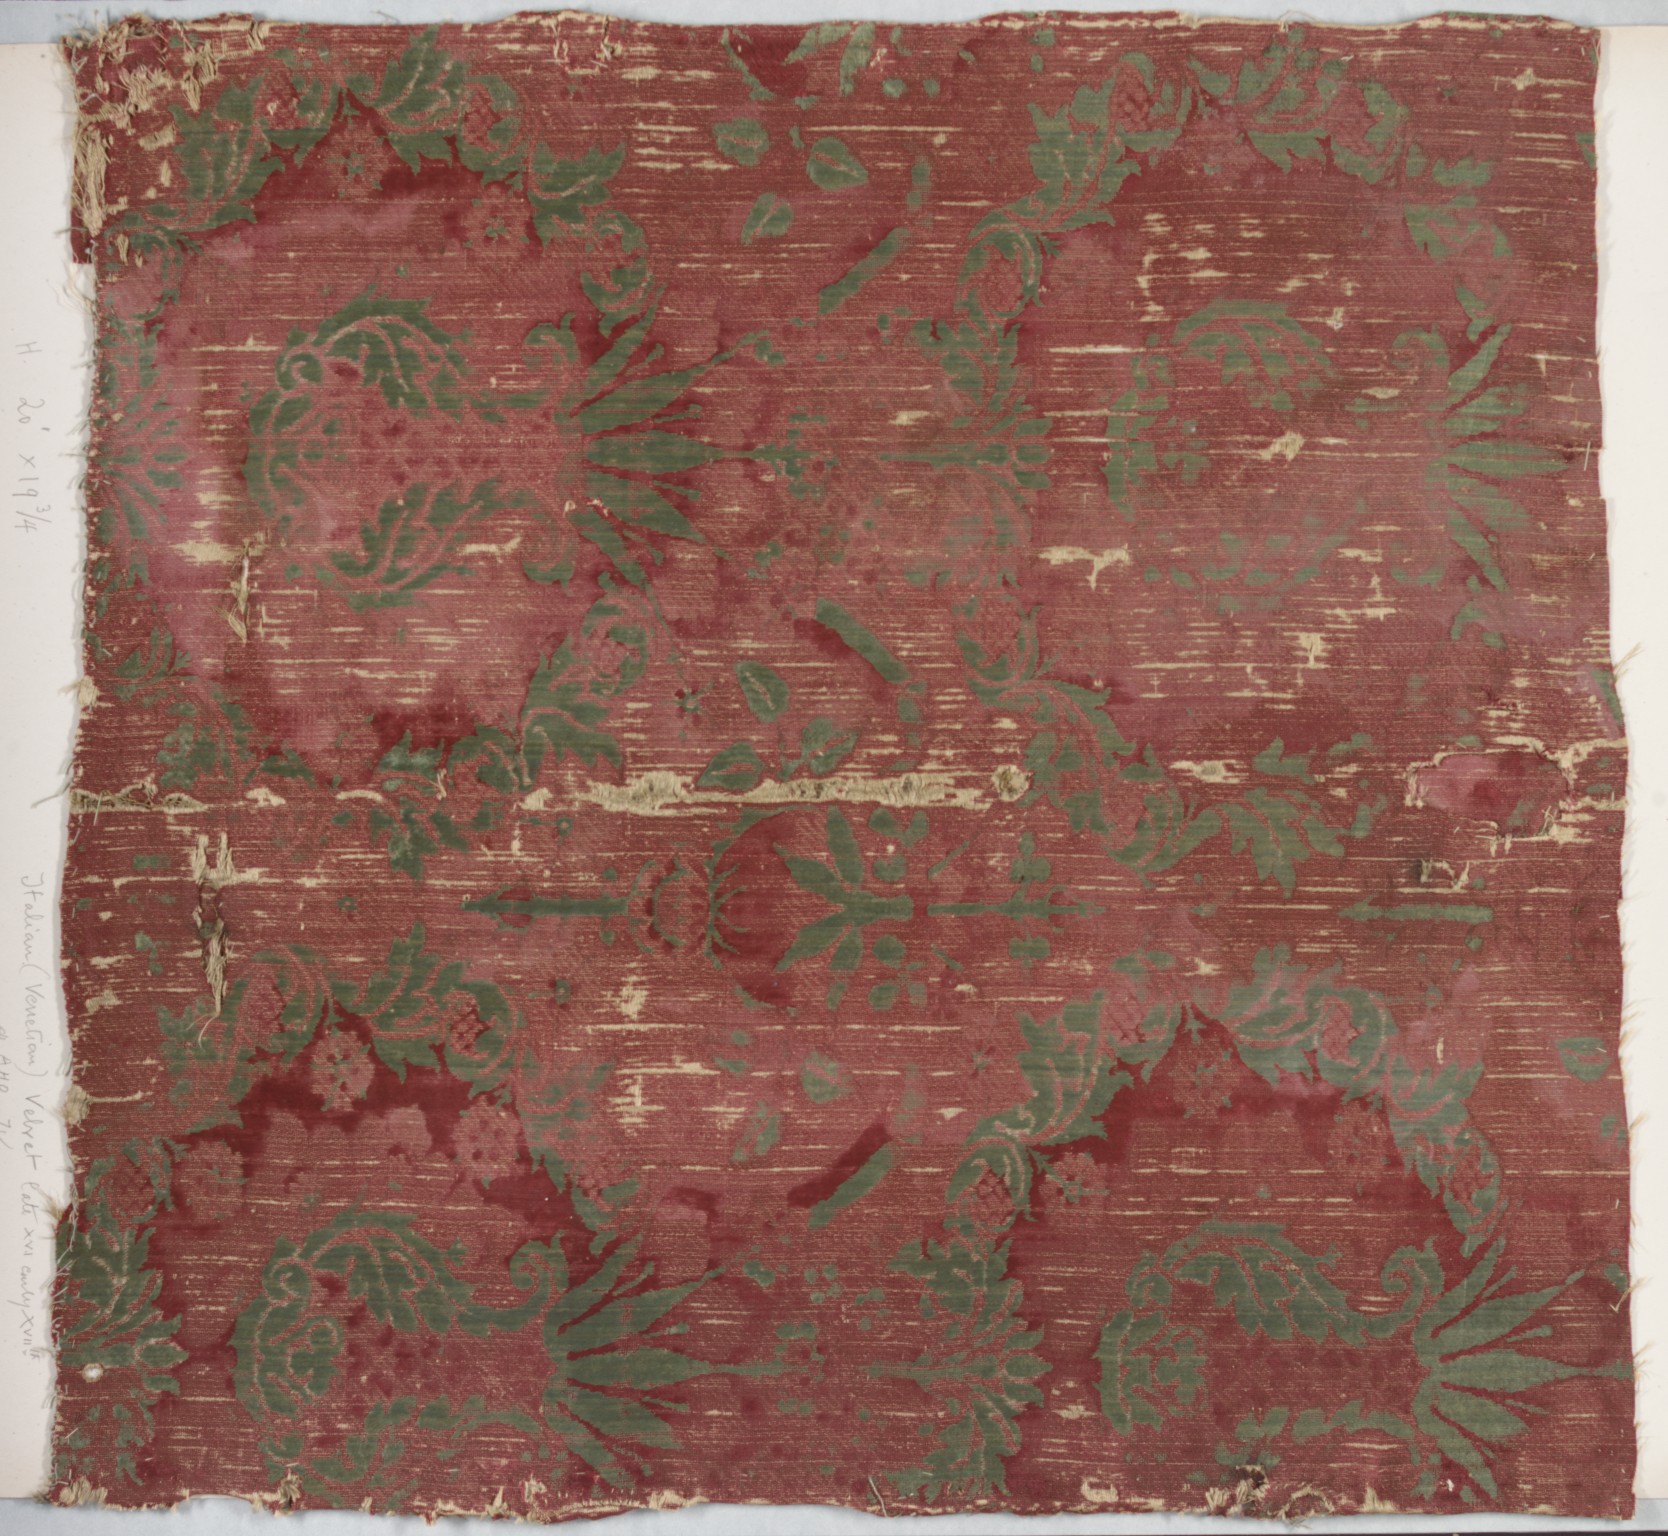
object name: fragment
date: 1567-1700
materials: silk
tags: flowers